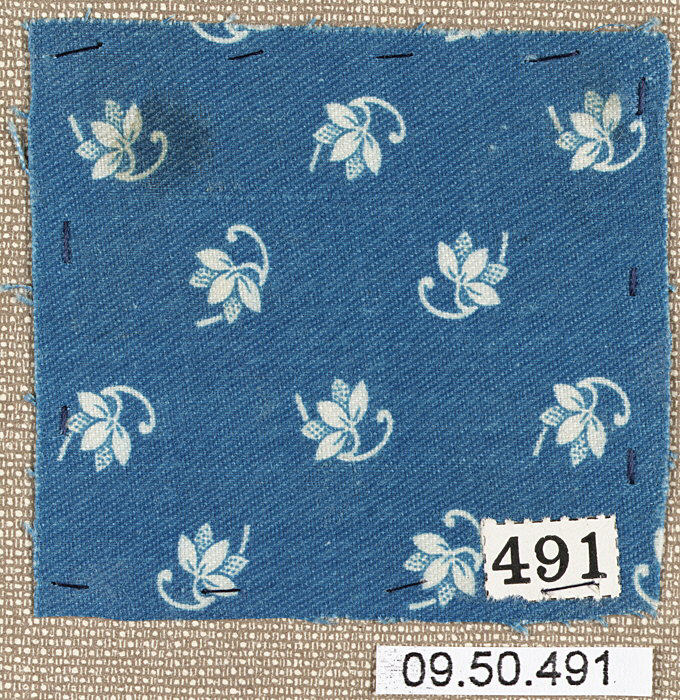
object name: piece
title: Piece (one of 13)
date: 1801-1900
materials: cotton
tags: leaves